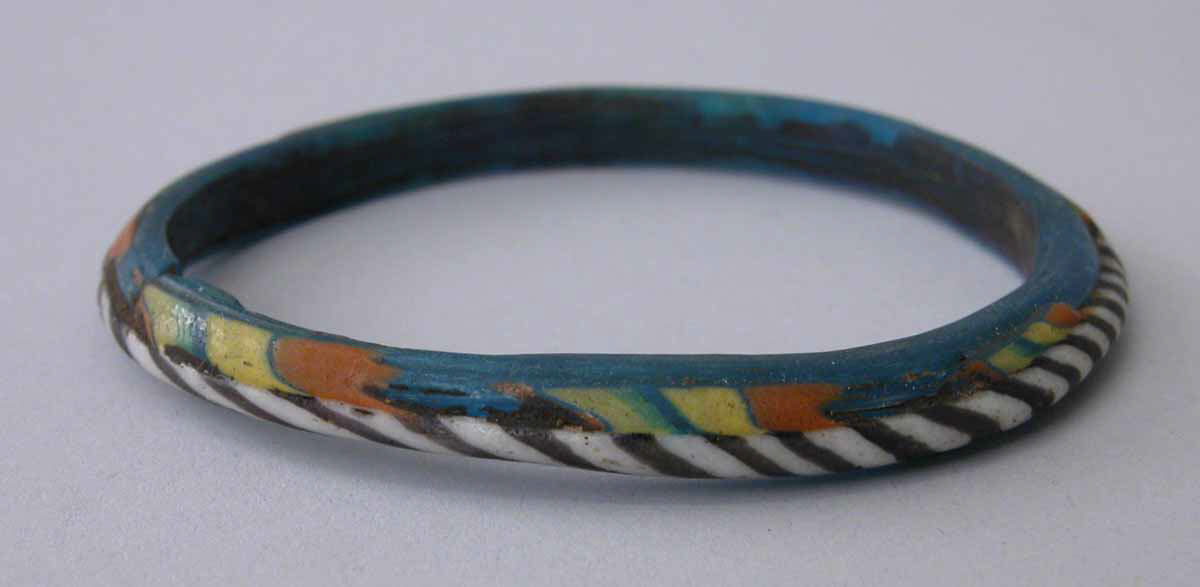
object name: bracelet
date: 1301-1500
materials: glass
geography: egypt or syria